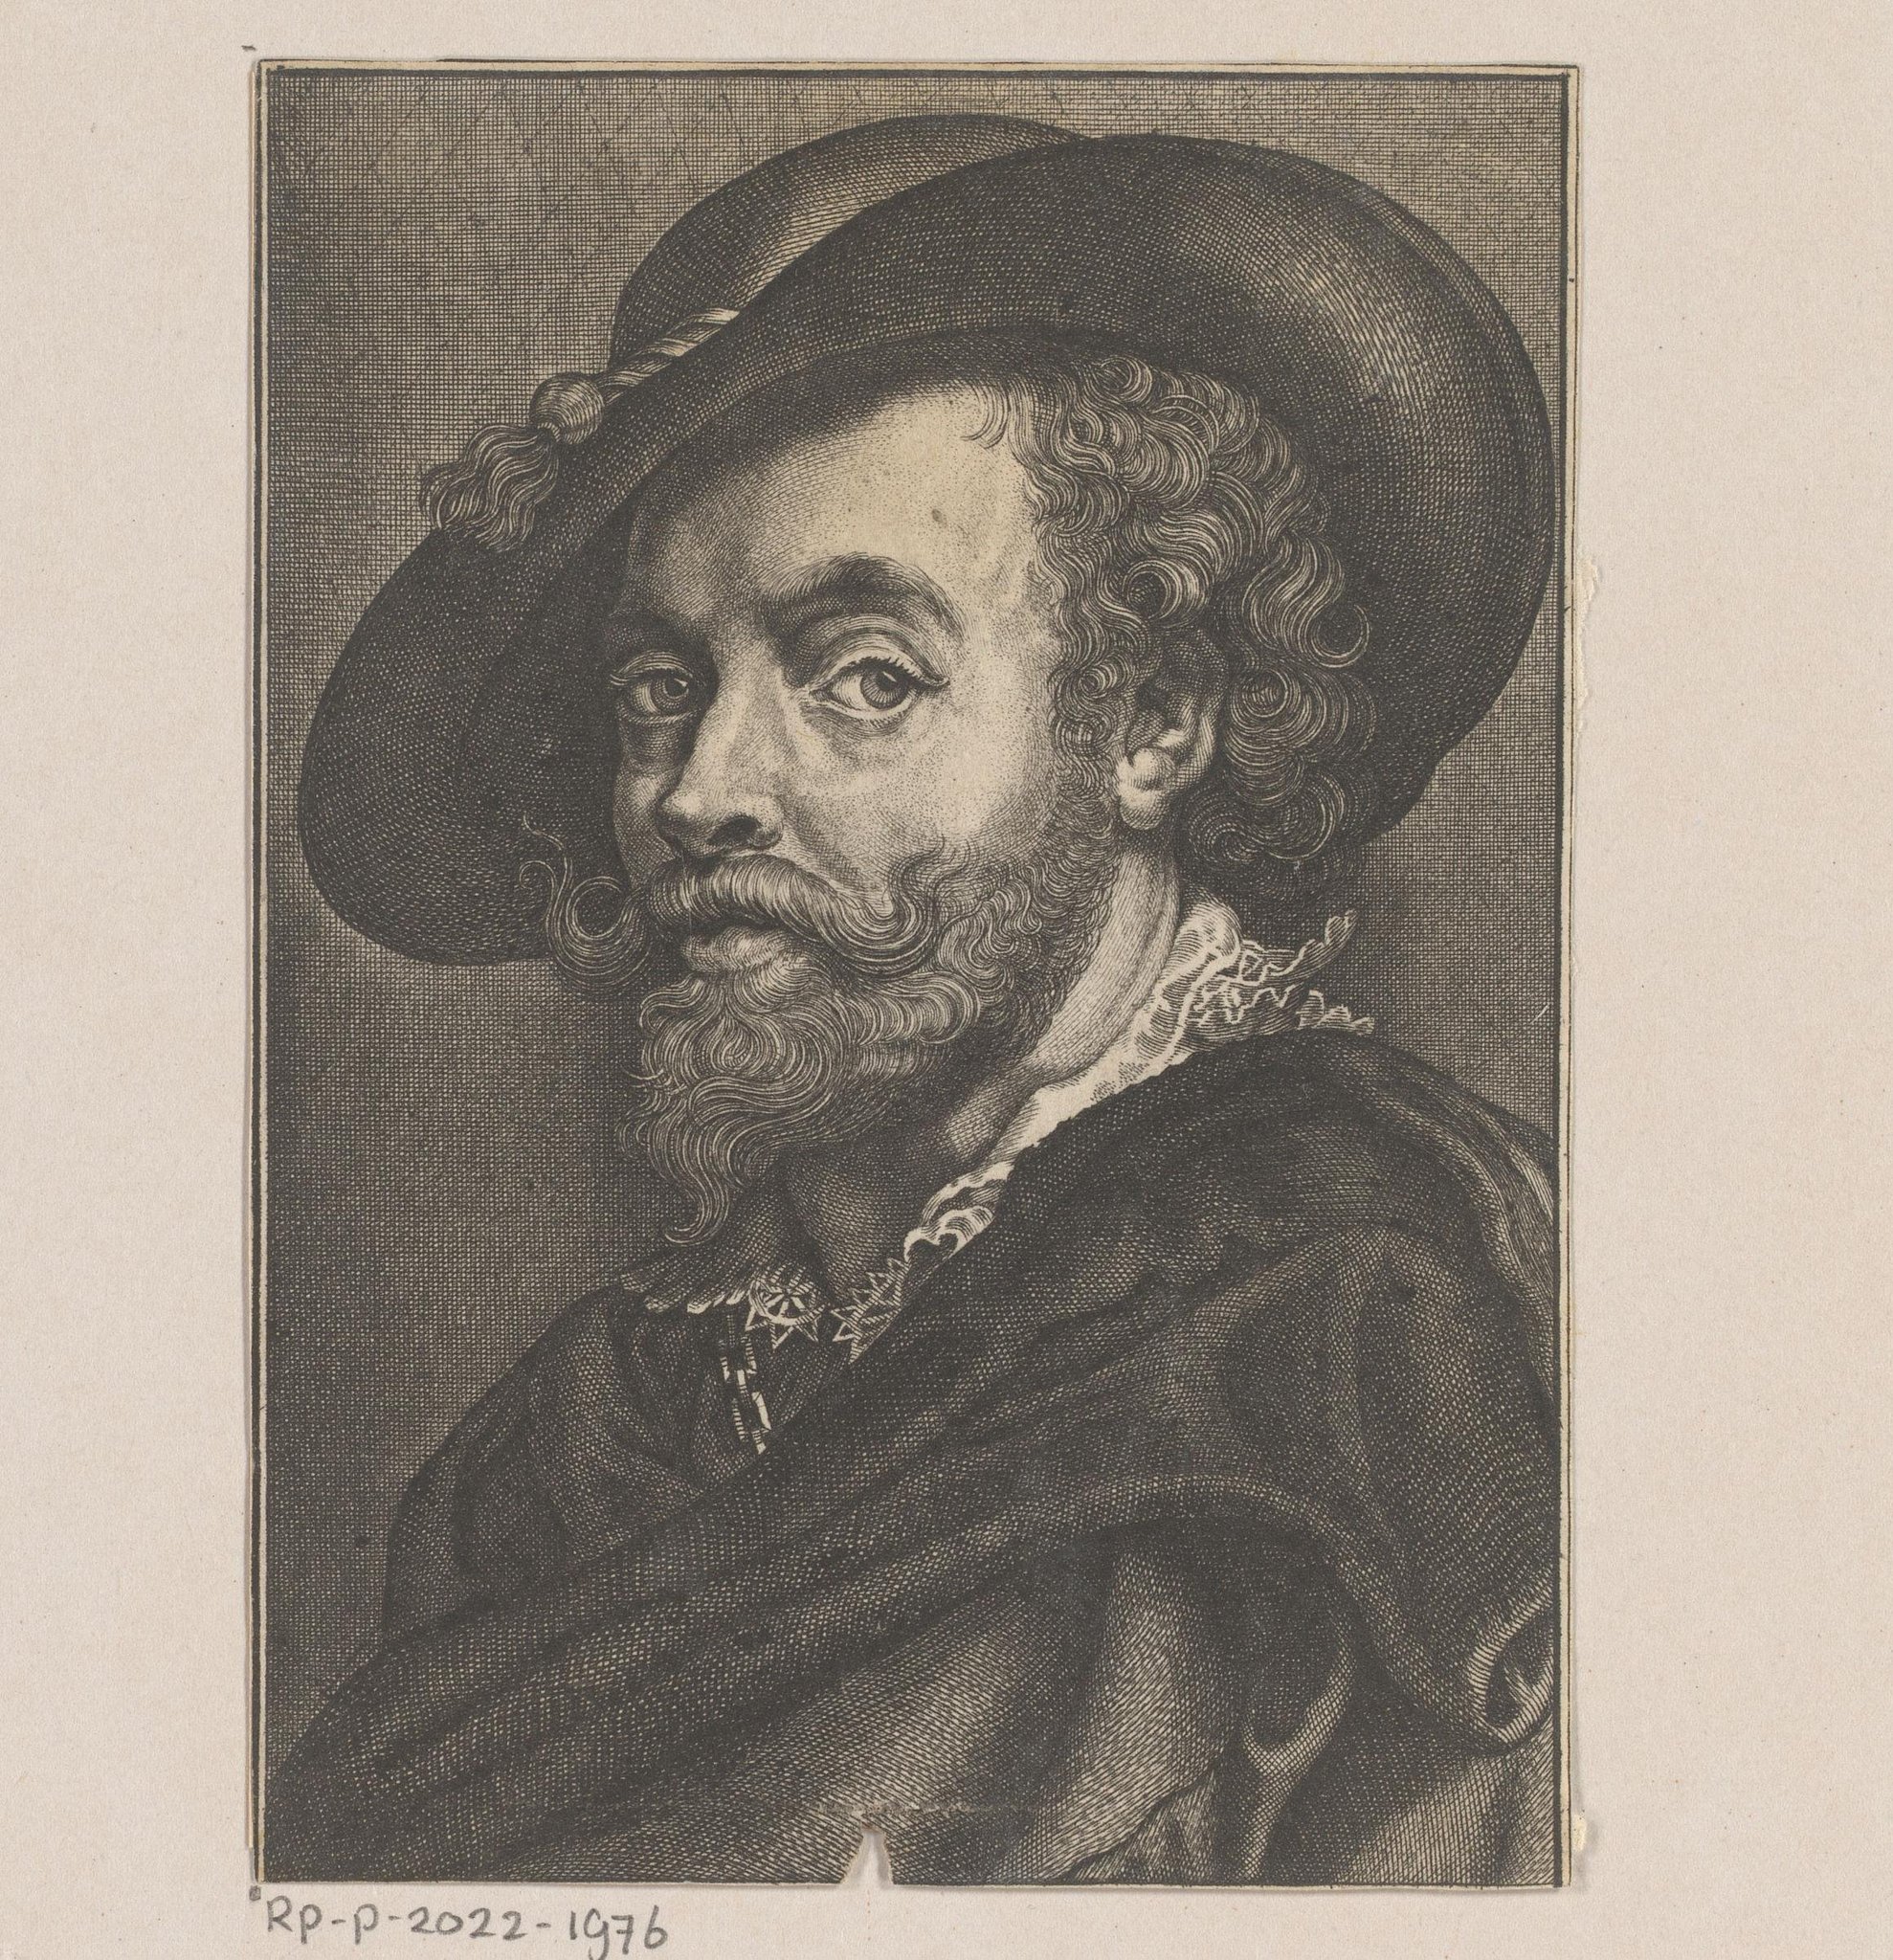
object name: print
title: Portret van Peter Paul Rubens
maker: jean henri van schawberg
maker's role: print maker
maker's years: 1717-1760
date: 1727-1760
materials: paper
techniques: engraving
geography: antwerp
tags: antwerp, painter, print maker, draughtsman, peter paul rubens, historical persons, portrait, self-portrait of artist